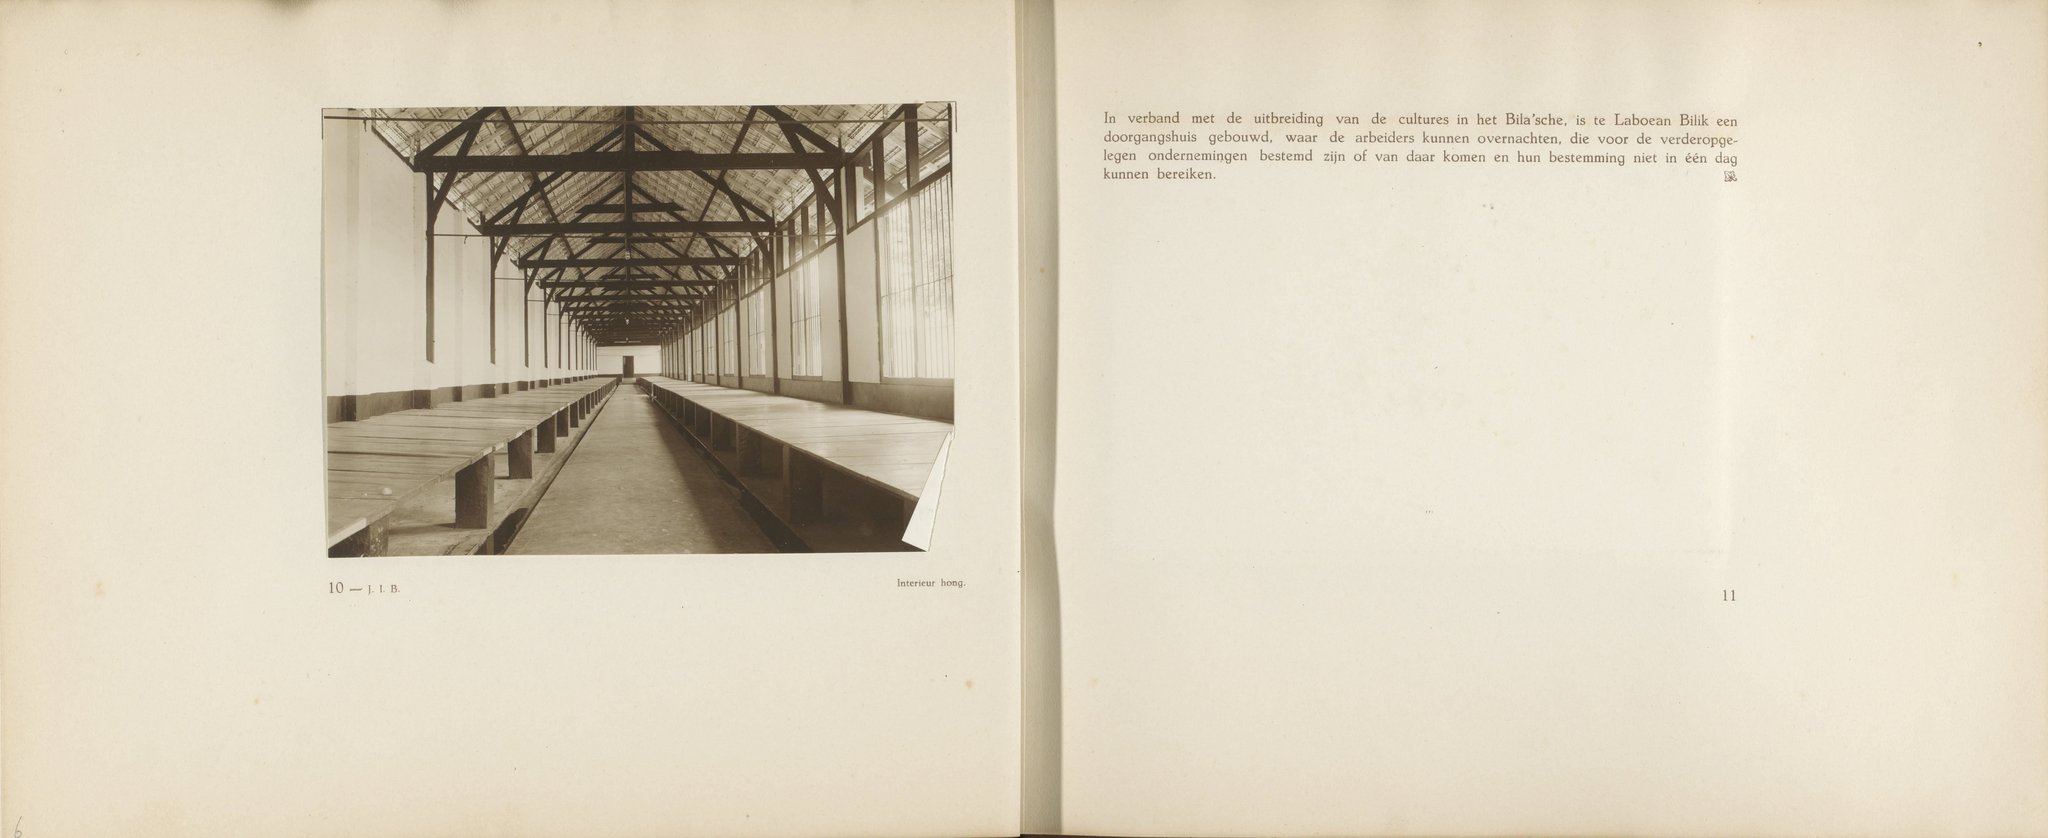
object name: album leaf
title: Pagina 10 en 11 van fotoboek van de Algemeene Vereeniging van Rubberplanters ter Oostkust van Sumatra (A.V.R.O.S.)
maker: j.w. meyster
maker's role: fotograaf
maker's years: 1887-1945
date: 1924-1925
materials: paper, photographic support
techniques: printing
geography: medan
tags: (non-fruit) products of plants or trees: rubber, barracks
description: Twee boekpagina's met links een foto van het interieur van een barak voor werkkrachten ('hong') te Medan en rechts informatie over het Java Immigranten Bureau (J.I.B.). Onderdeel van een fotoboek van de Algemeene Vereeniging van Rubberplanters ter Oostkust van Sumatra (A.V.R.O.S.).